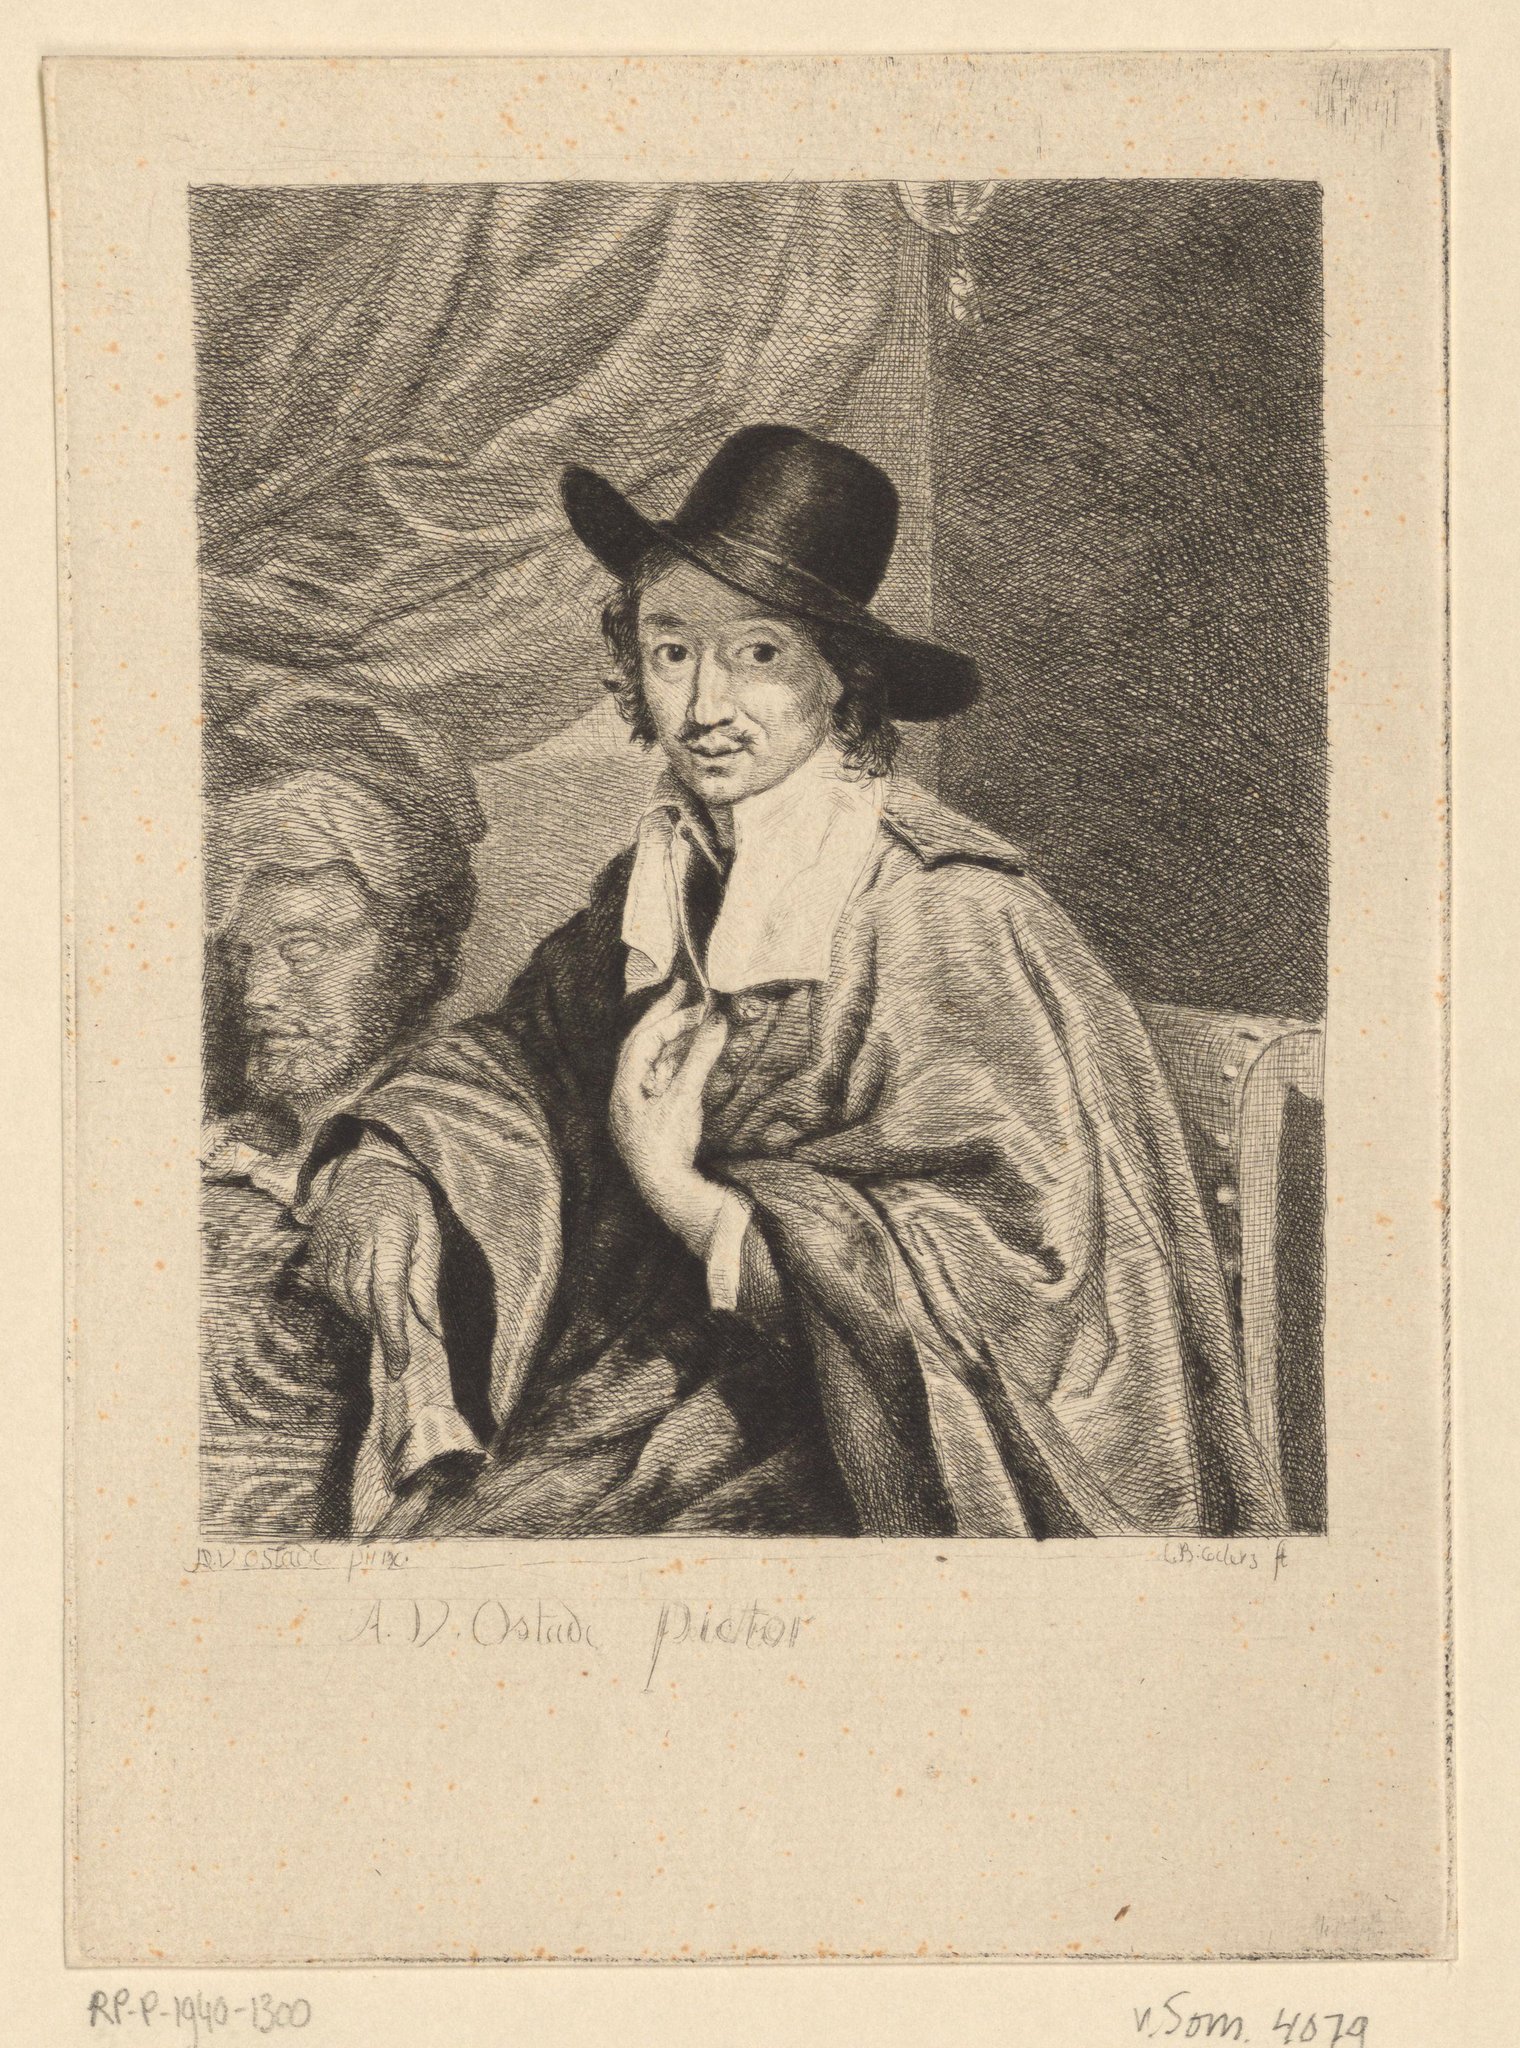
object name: print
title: Portret van Adriaen van Ostade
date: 1756-1817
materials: paper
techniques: drypoint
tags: haarlem, painter, draughtsman, adriaen van ostade, historical persons, portrait, self-portrait of painter, portrait, self-portrait of artist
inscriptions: collector's mark: Lugt 2760, collector's mark: Lugt 2228